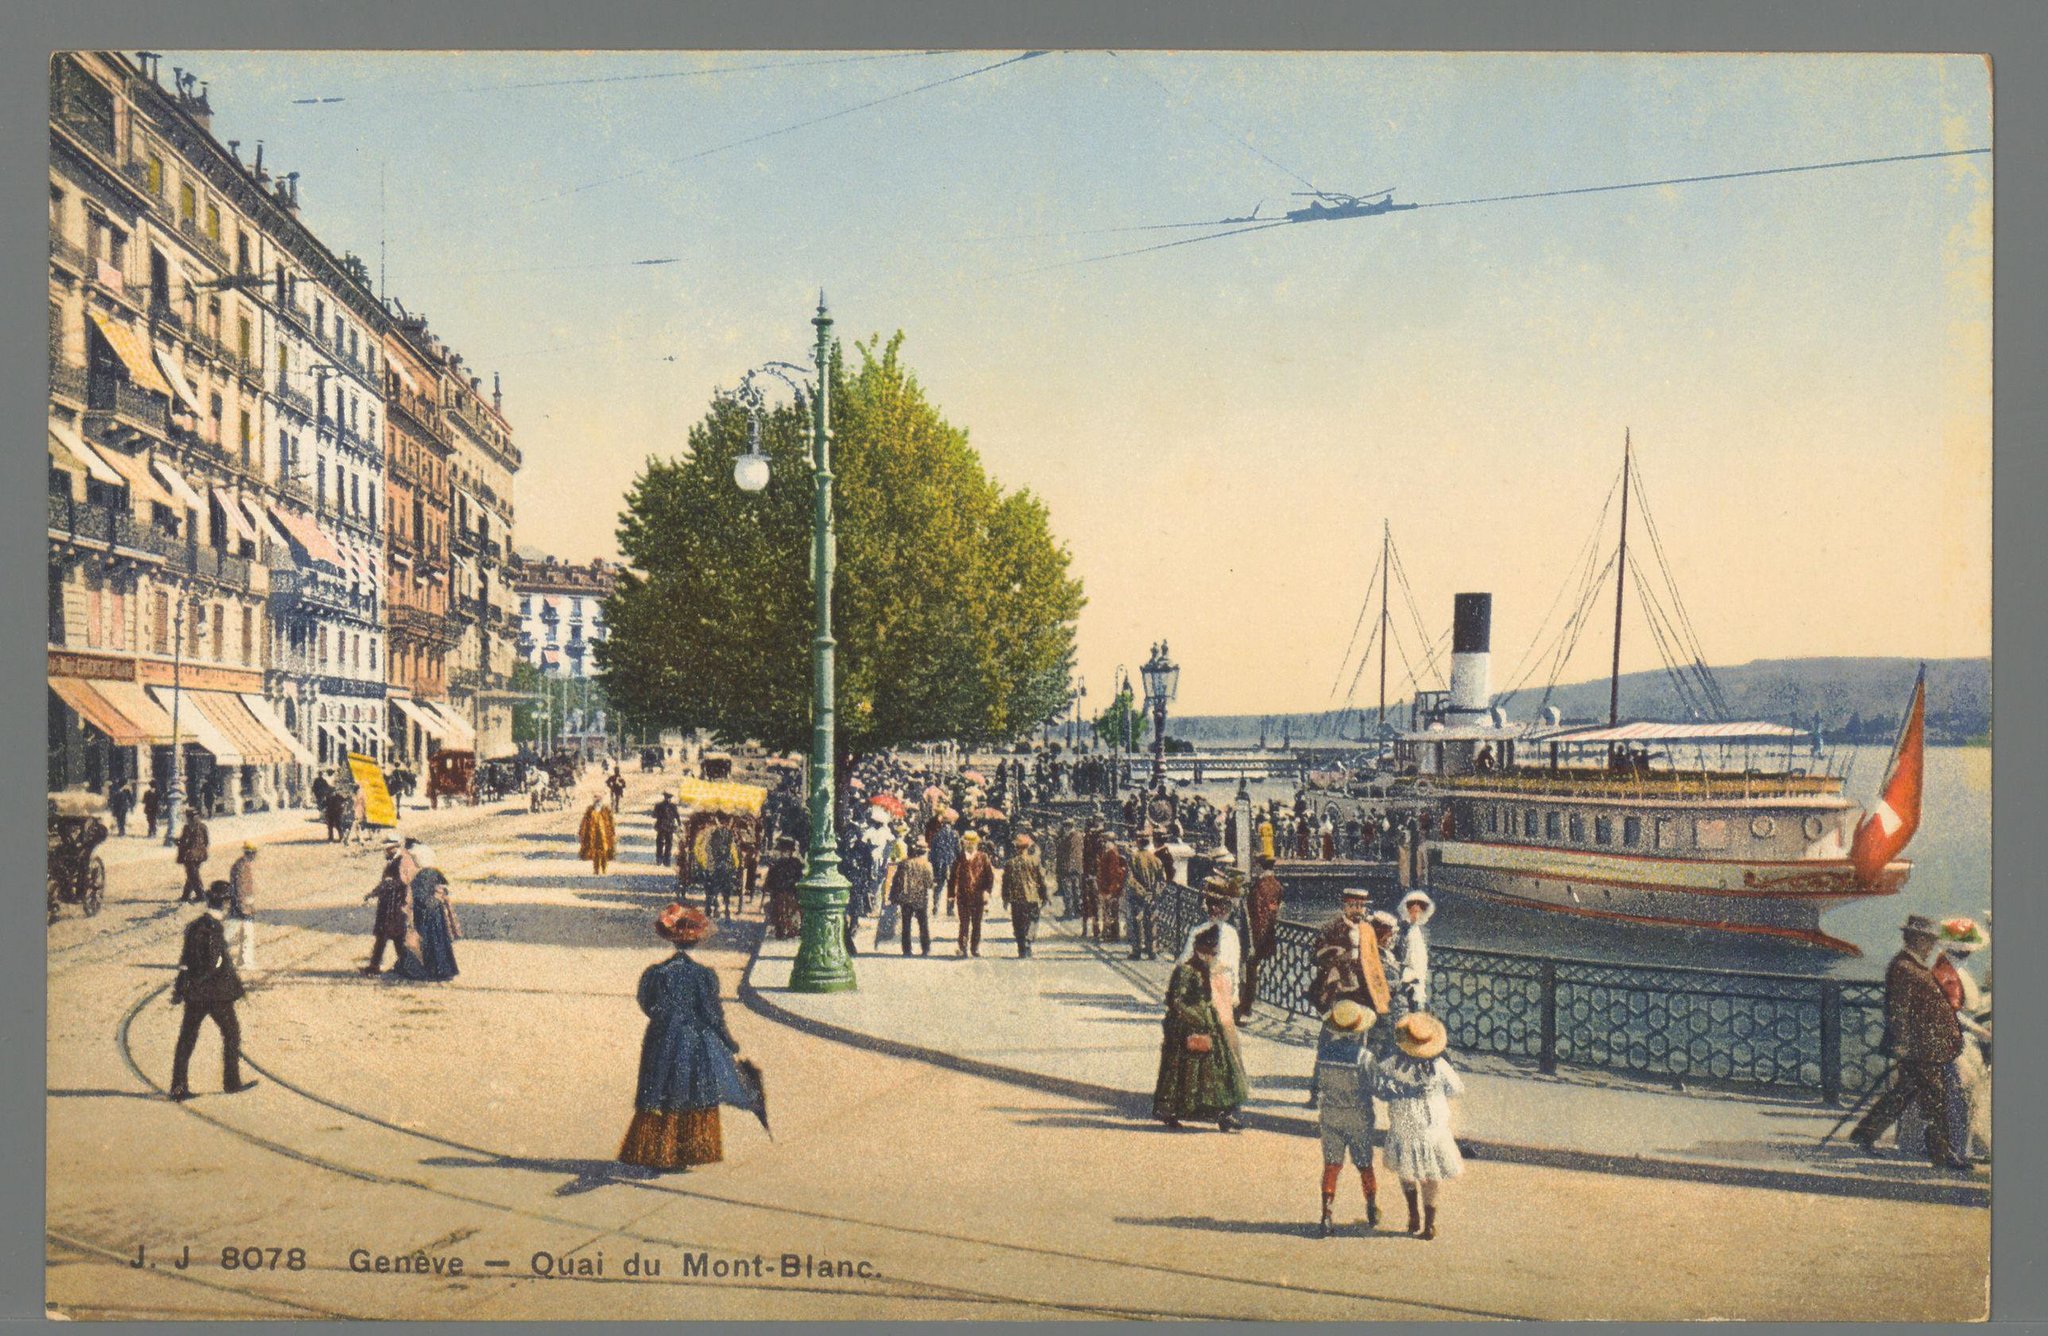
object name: ansichtkaart, prentbriefkaart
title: Genève. Quai du Mont-Blanc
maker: Anonymous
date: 1905-1918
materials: cardboard, photographic process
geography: geneva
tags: lake, pier, quay, wharf, city-view, and landscape with man-made constructions (+ city(-scape) with figures, staffage)